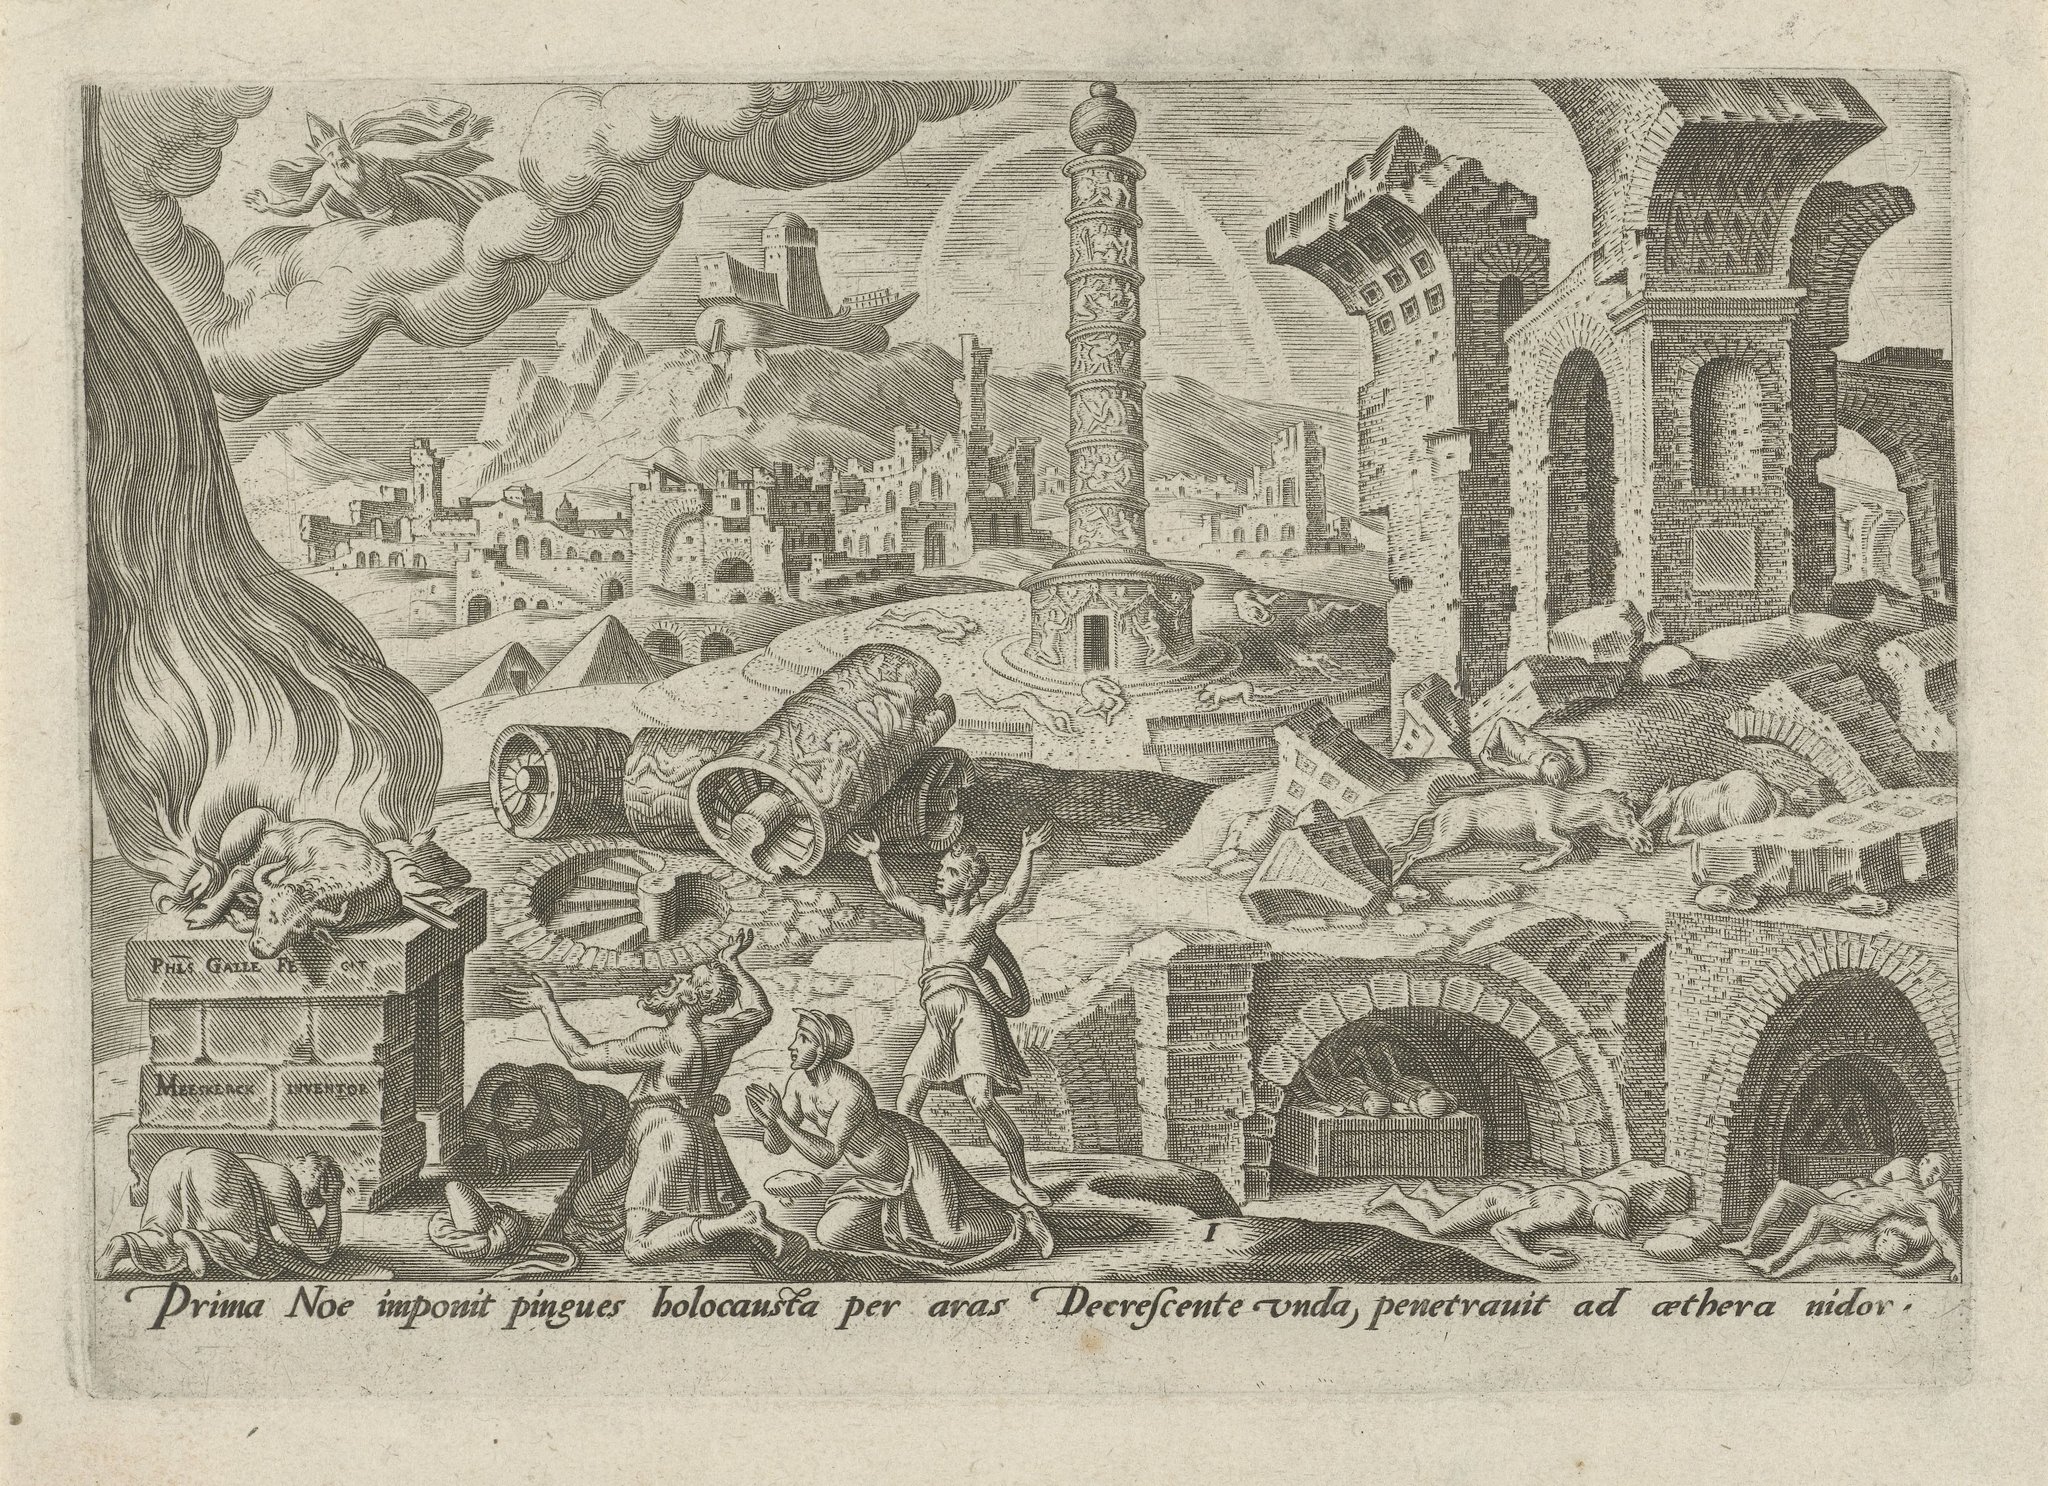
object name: print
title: Offer van Noach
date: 1569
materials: paper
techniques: engraving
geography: haarlem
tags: noah's sacrifice; various animals are offered, possibly a lamb, a dove and a ram (often combined with the rainbow of the covenant)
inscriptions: signature: ‘Phils Galle fecit’, caption: ‘Prima Noe imponit pingues holocausta per aras / Decrescente unda, penetravit ad aethera nidor.’, collector's mark: Lugt 2228, signature: ‘MHEE[M]SKERCK INVENTOR’, number: ‘1’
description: Links op de voorgrond worden verschillende dieren geofferd. Noach en zijn familieleden liggen geknield voor het brandoffer. Op de achtergrond verwoeste gebouwen en dode mensen op de grond. Linksboven in een wolk God de vader.